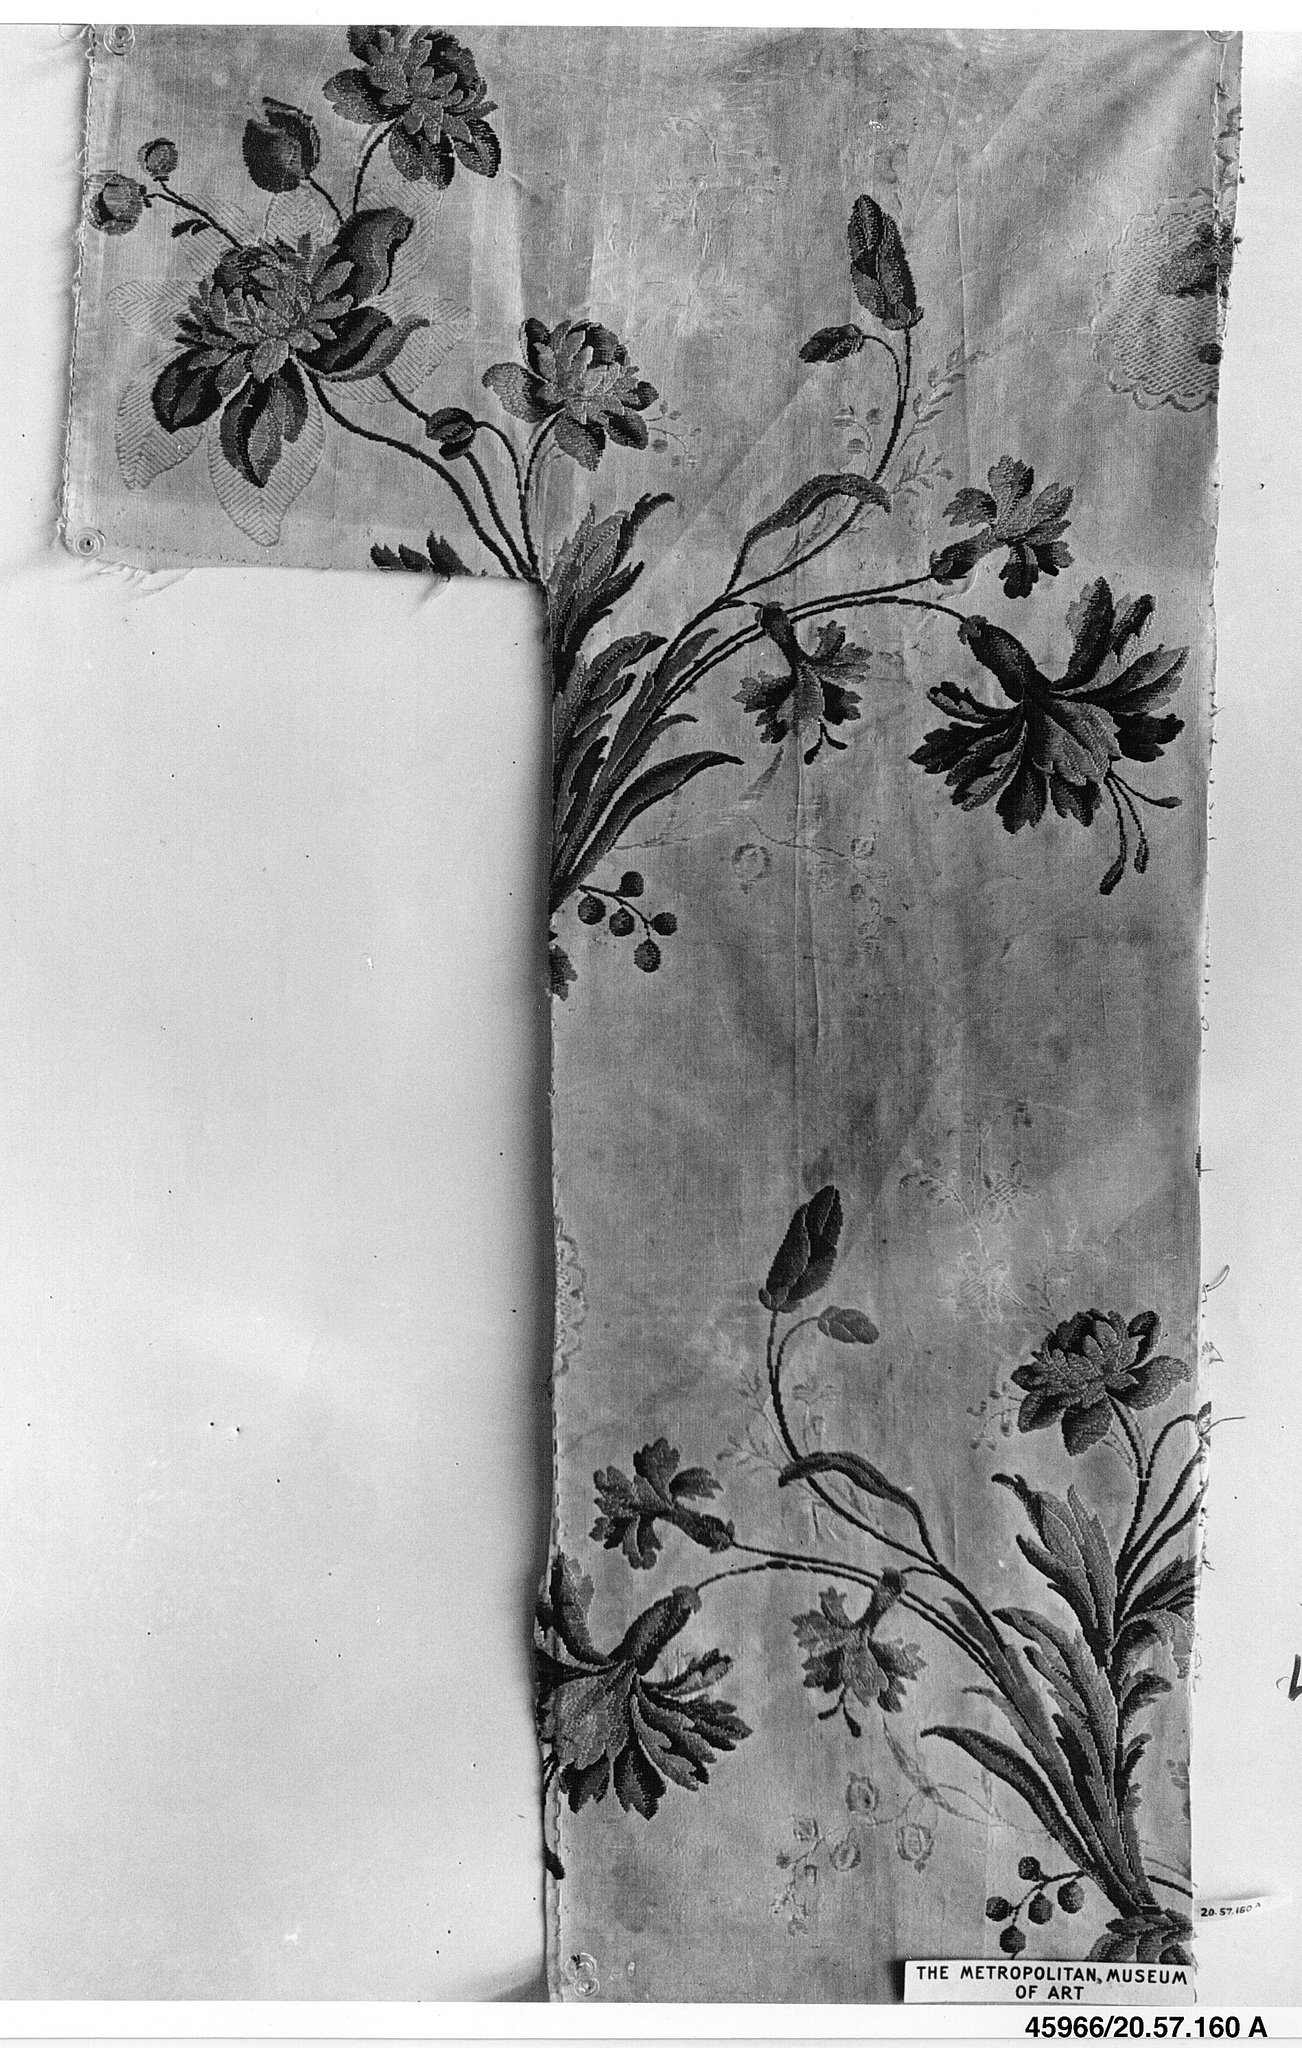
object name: piece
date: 1750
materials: silk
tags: flowers,leaves